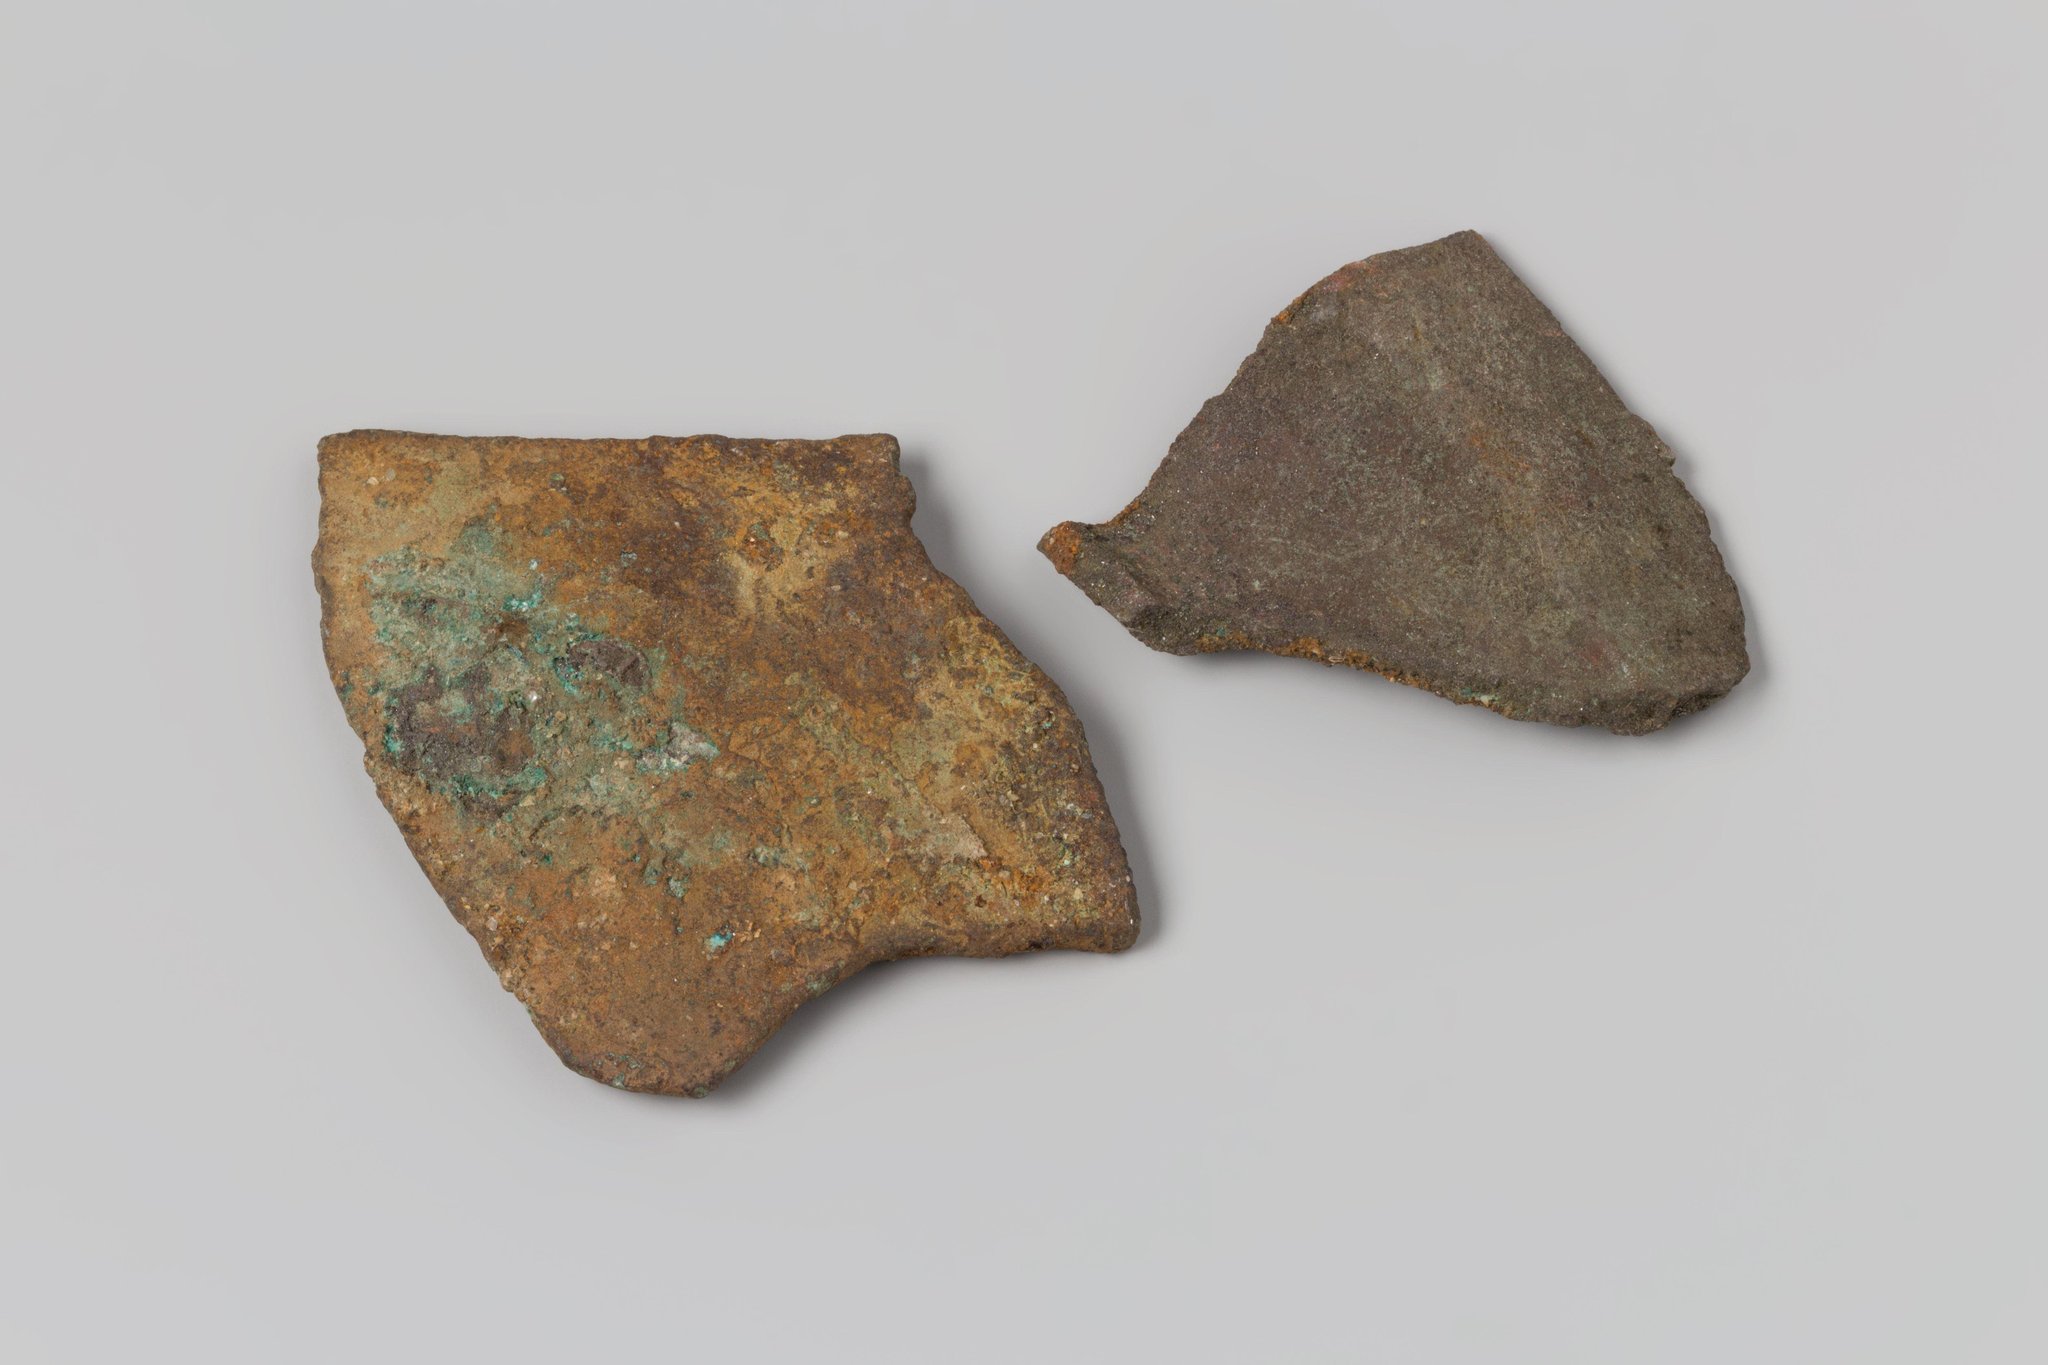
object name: scheepswrakvondst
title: Fragment van koper en aardewerk uit het wrak van de Oost-Indiëvaarder Hollandia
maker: Anonymous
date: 1700-1743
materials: copper, earthenware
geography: netherlands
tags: verenigde oostindische compagnie, hollandia (schip), annet